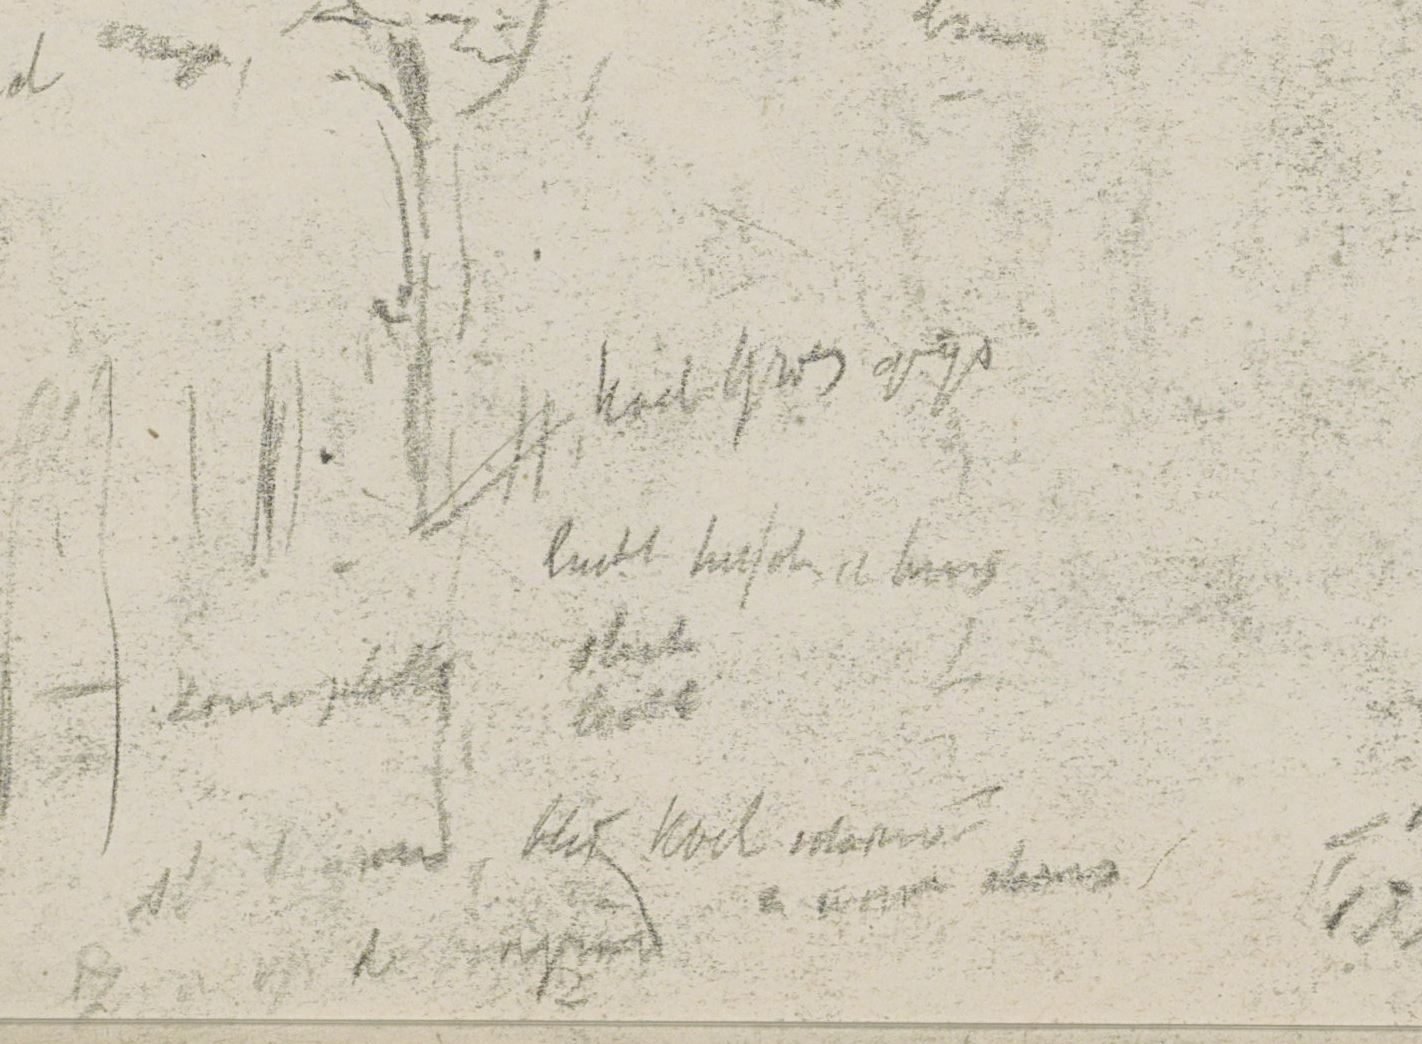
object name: sketchbook leaf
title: Bomen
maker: johan antonie de jonge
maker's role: draughtsman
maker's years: 1864-1927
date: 1884-1927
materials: chalk, paper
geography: south holland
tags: trees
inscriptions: kleurnotitie, handgeschreven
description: Bomen. Blad 27 recto uit een schetsboek met 33 bladen.